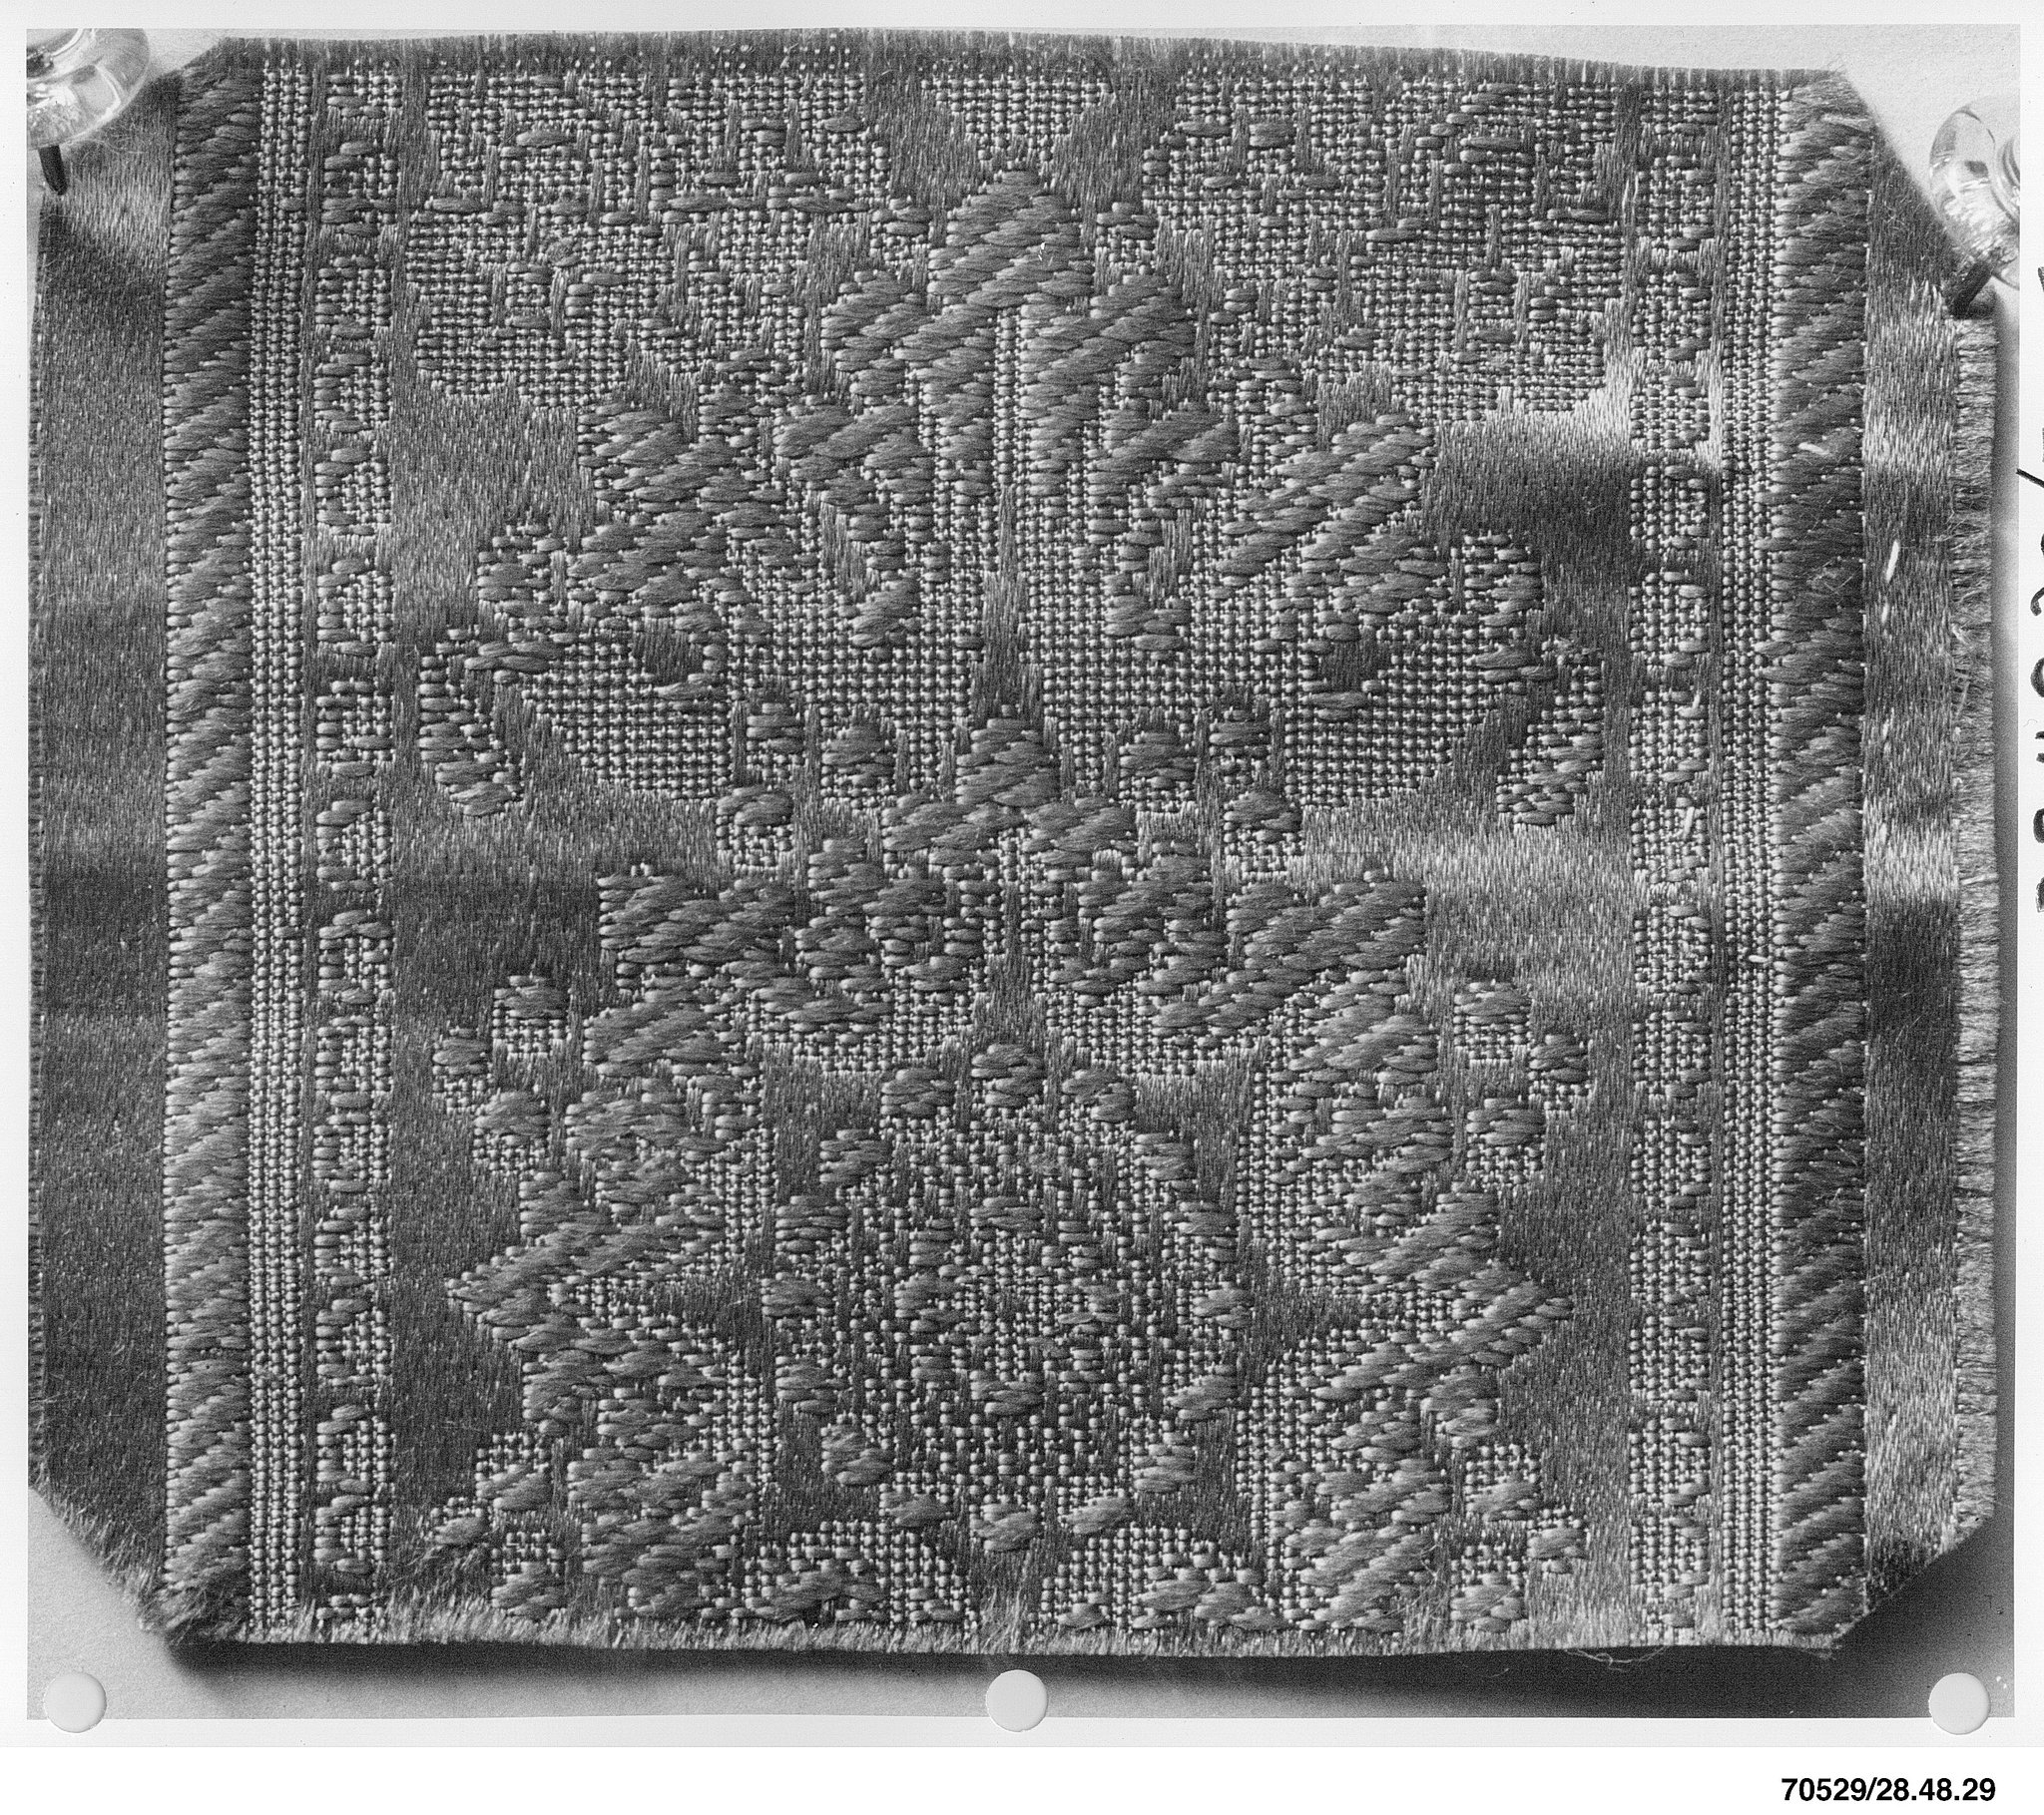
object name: border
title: Part of a border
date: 1801-1900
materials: silk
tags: flowers